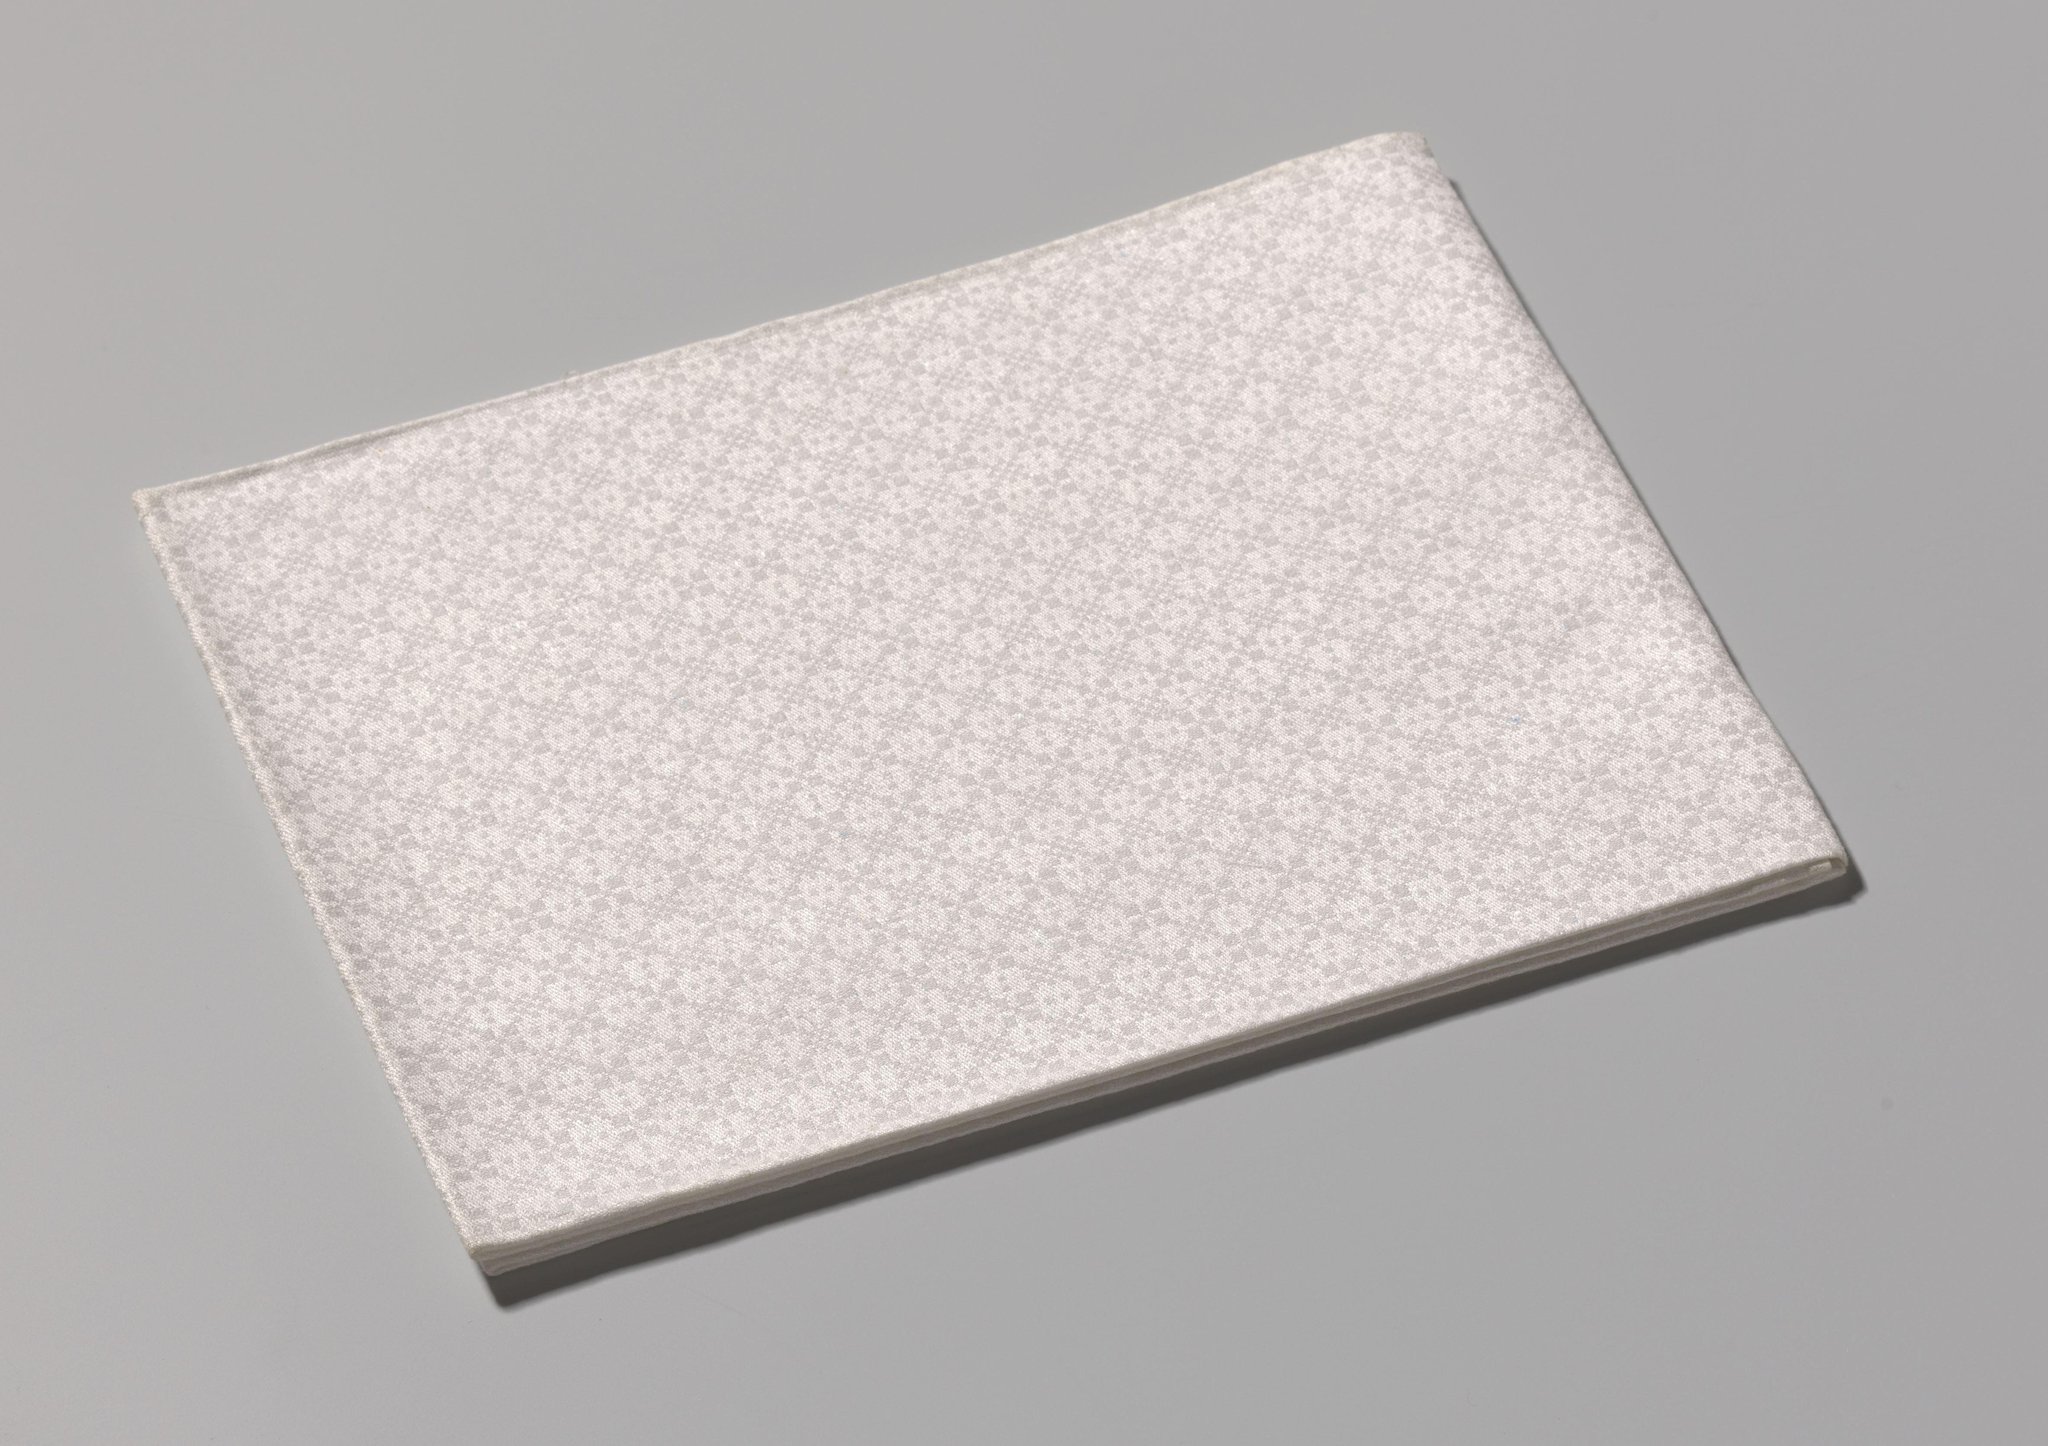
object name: napkin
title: Servet van linnen met pellenpatroon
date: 1627-1666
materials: linen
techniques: peeled fabric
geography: northern netherlands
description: wit linnen servet met pellen patroon, merk kroon IVG